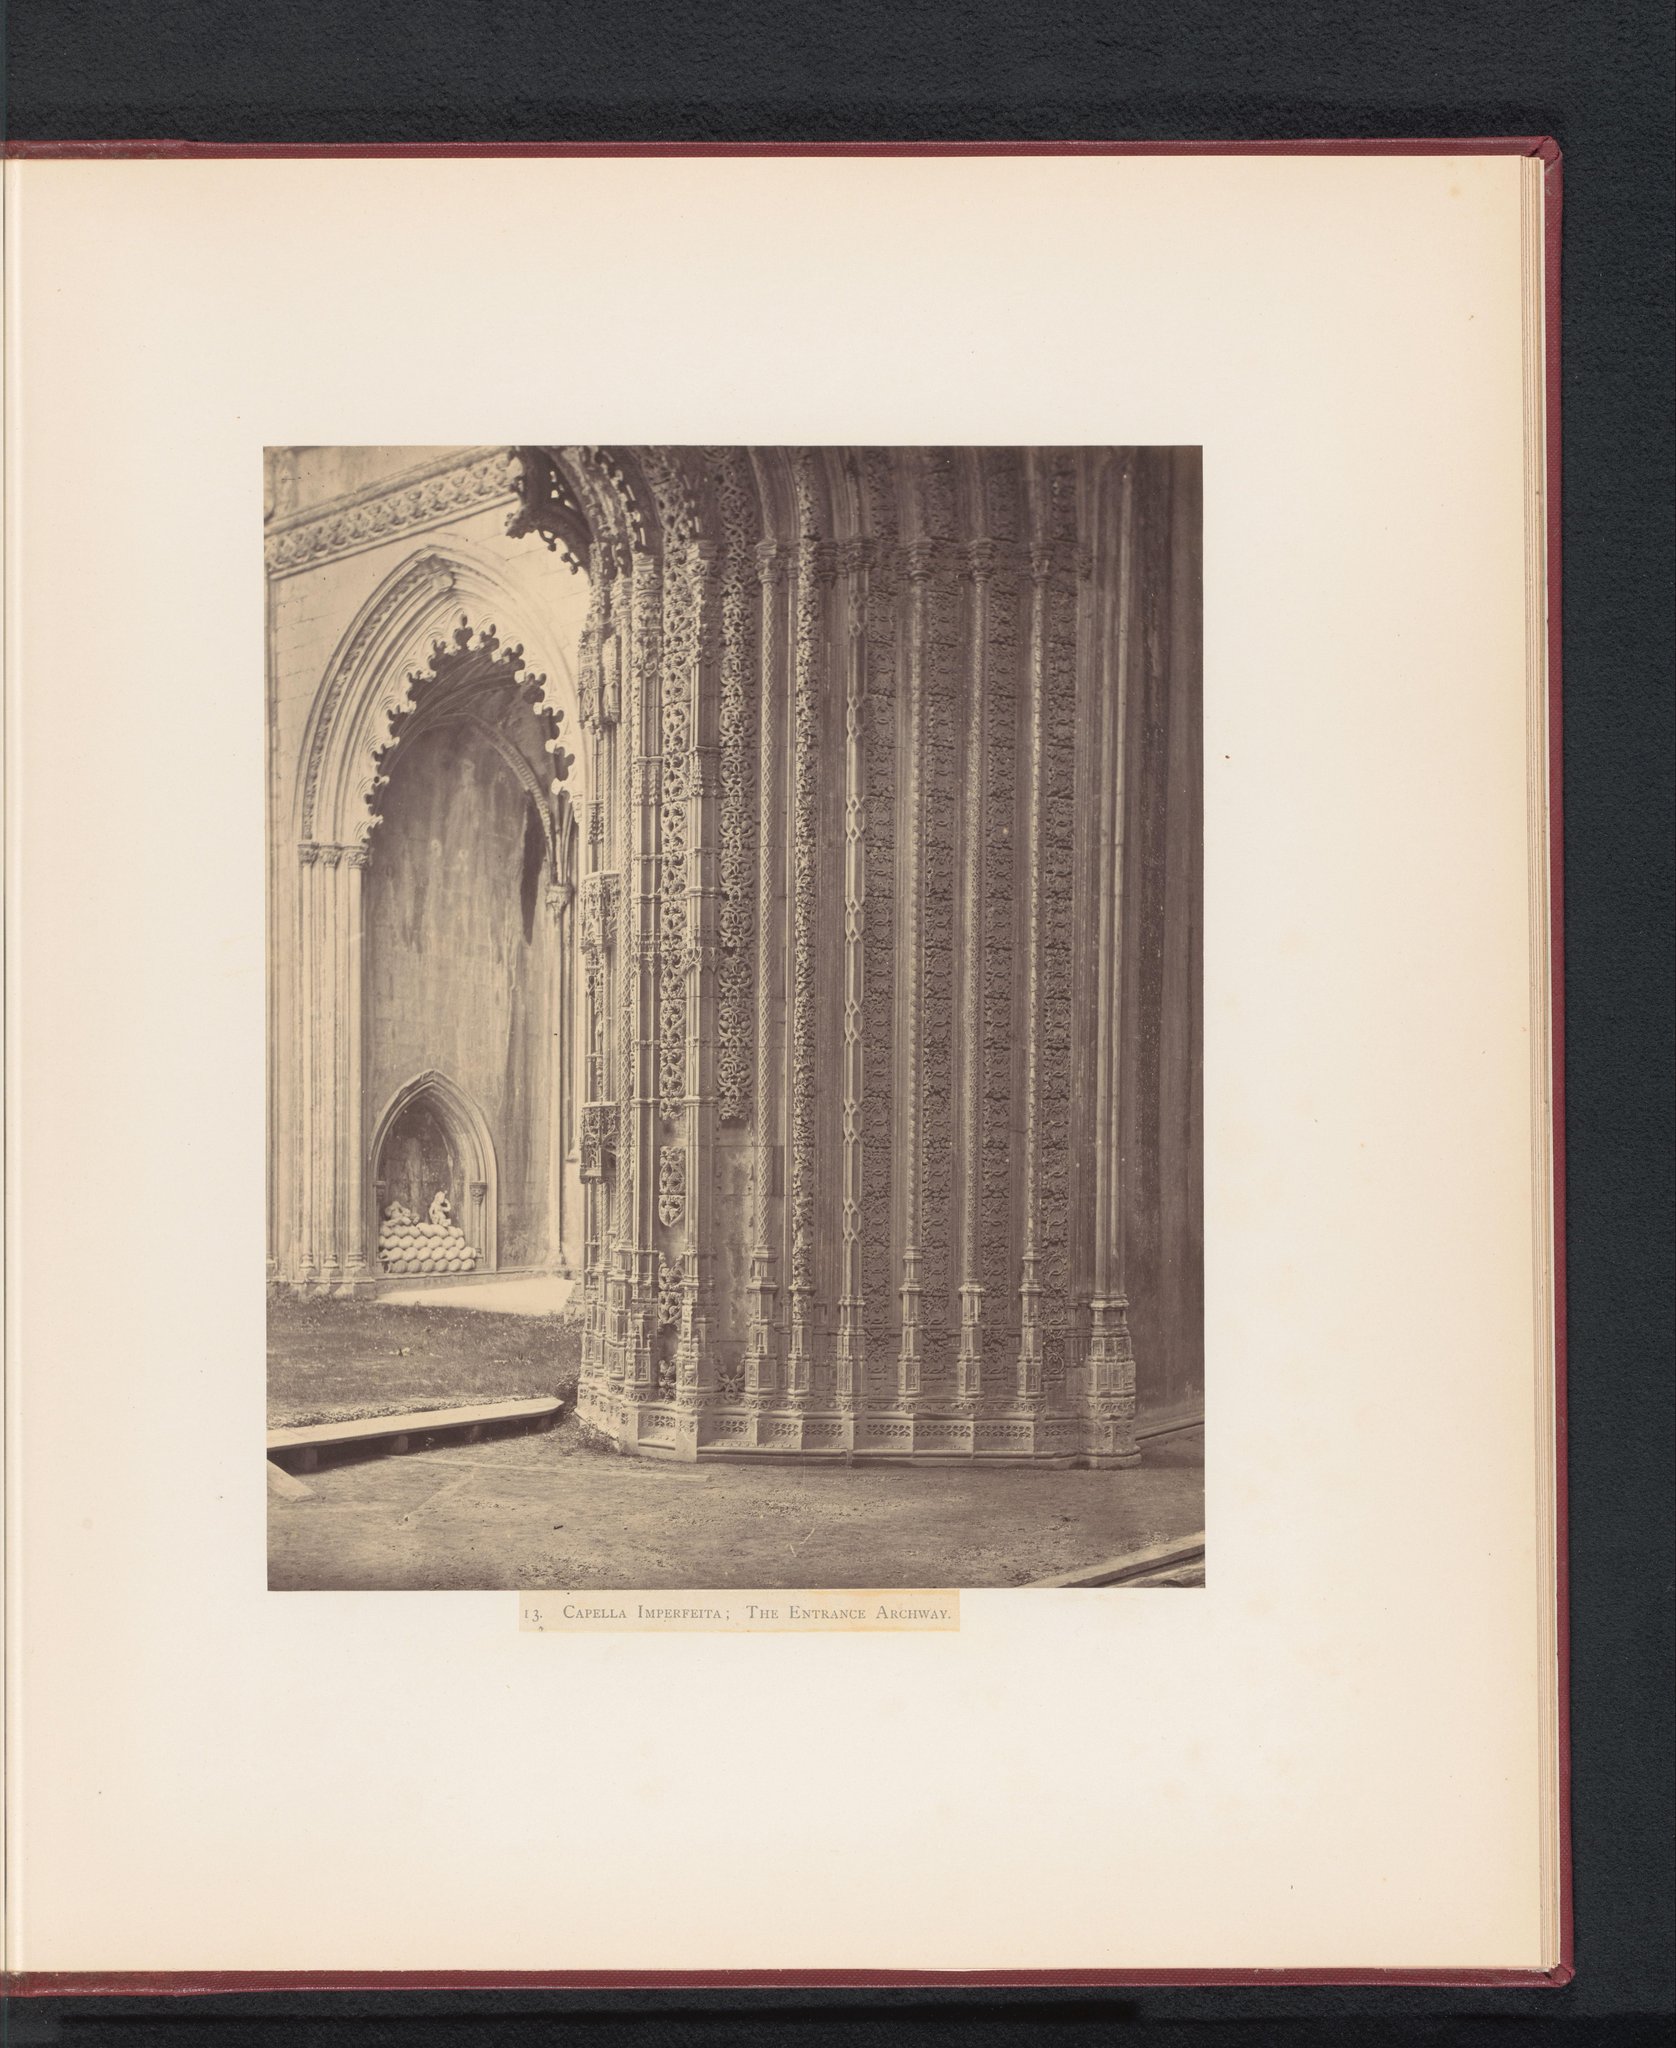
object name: photograph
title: Gezicht op de toegangsboog van het klooster van Batalha, Portugal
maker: charles thurston thompson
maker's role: fotograaf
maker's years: 1816-1868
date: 1863-1868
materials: photographic support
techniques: albumen print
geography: batalha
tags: arch, archivolt ~ architecture, cloisters ~ monastery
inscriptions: number: ‘13.’